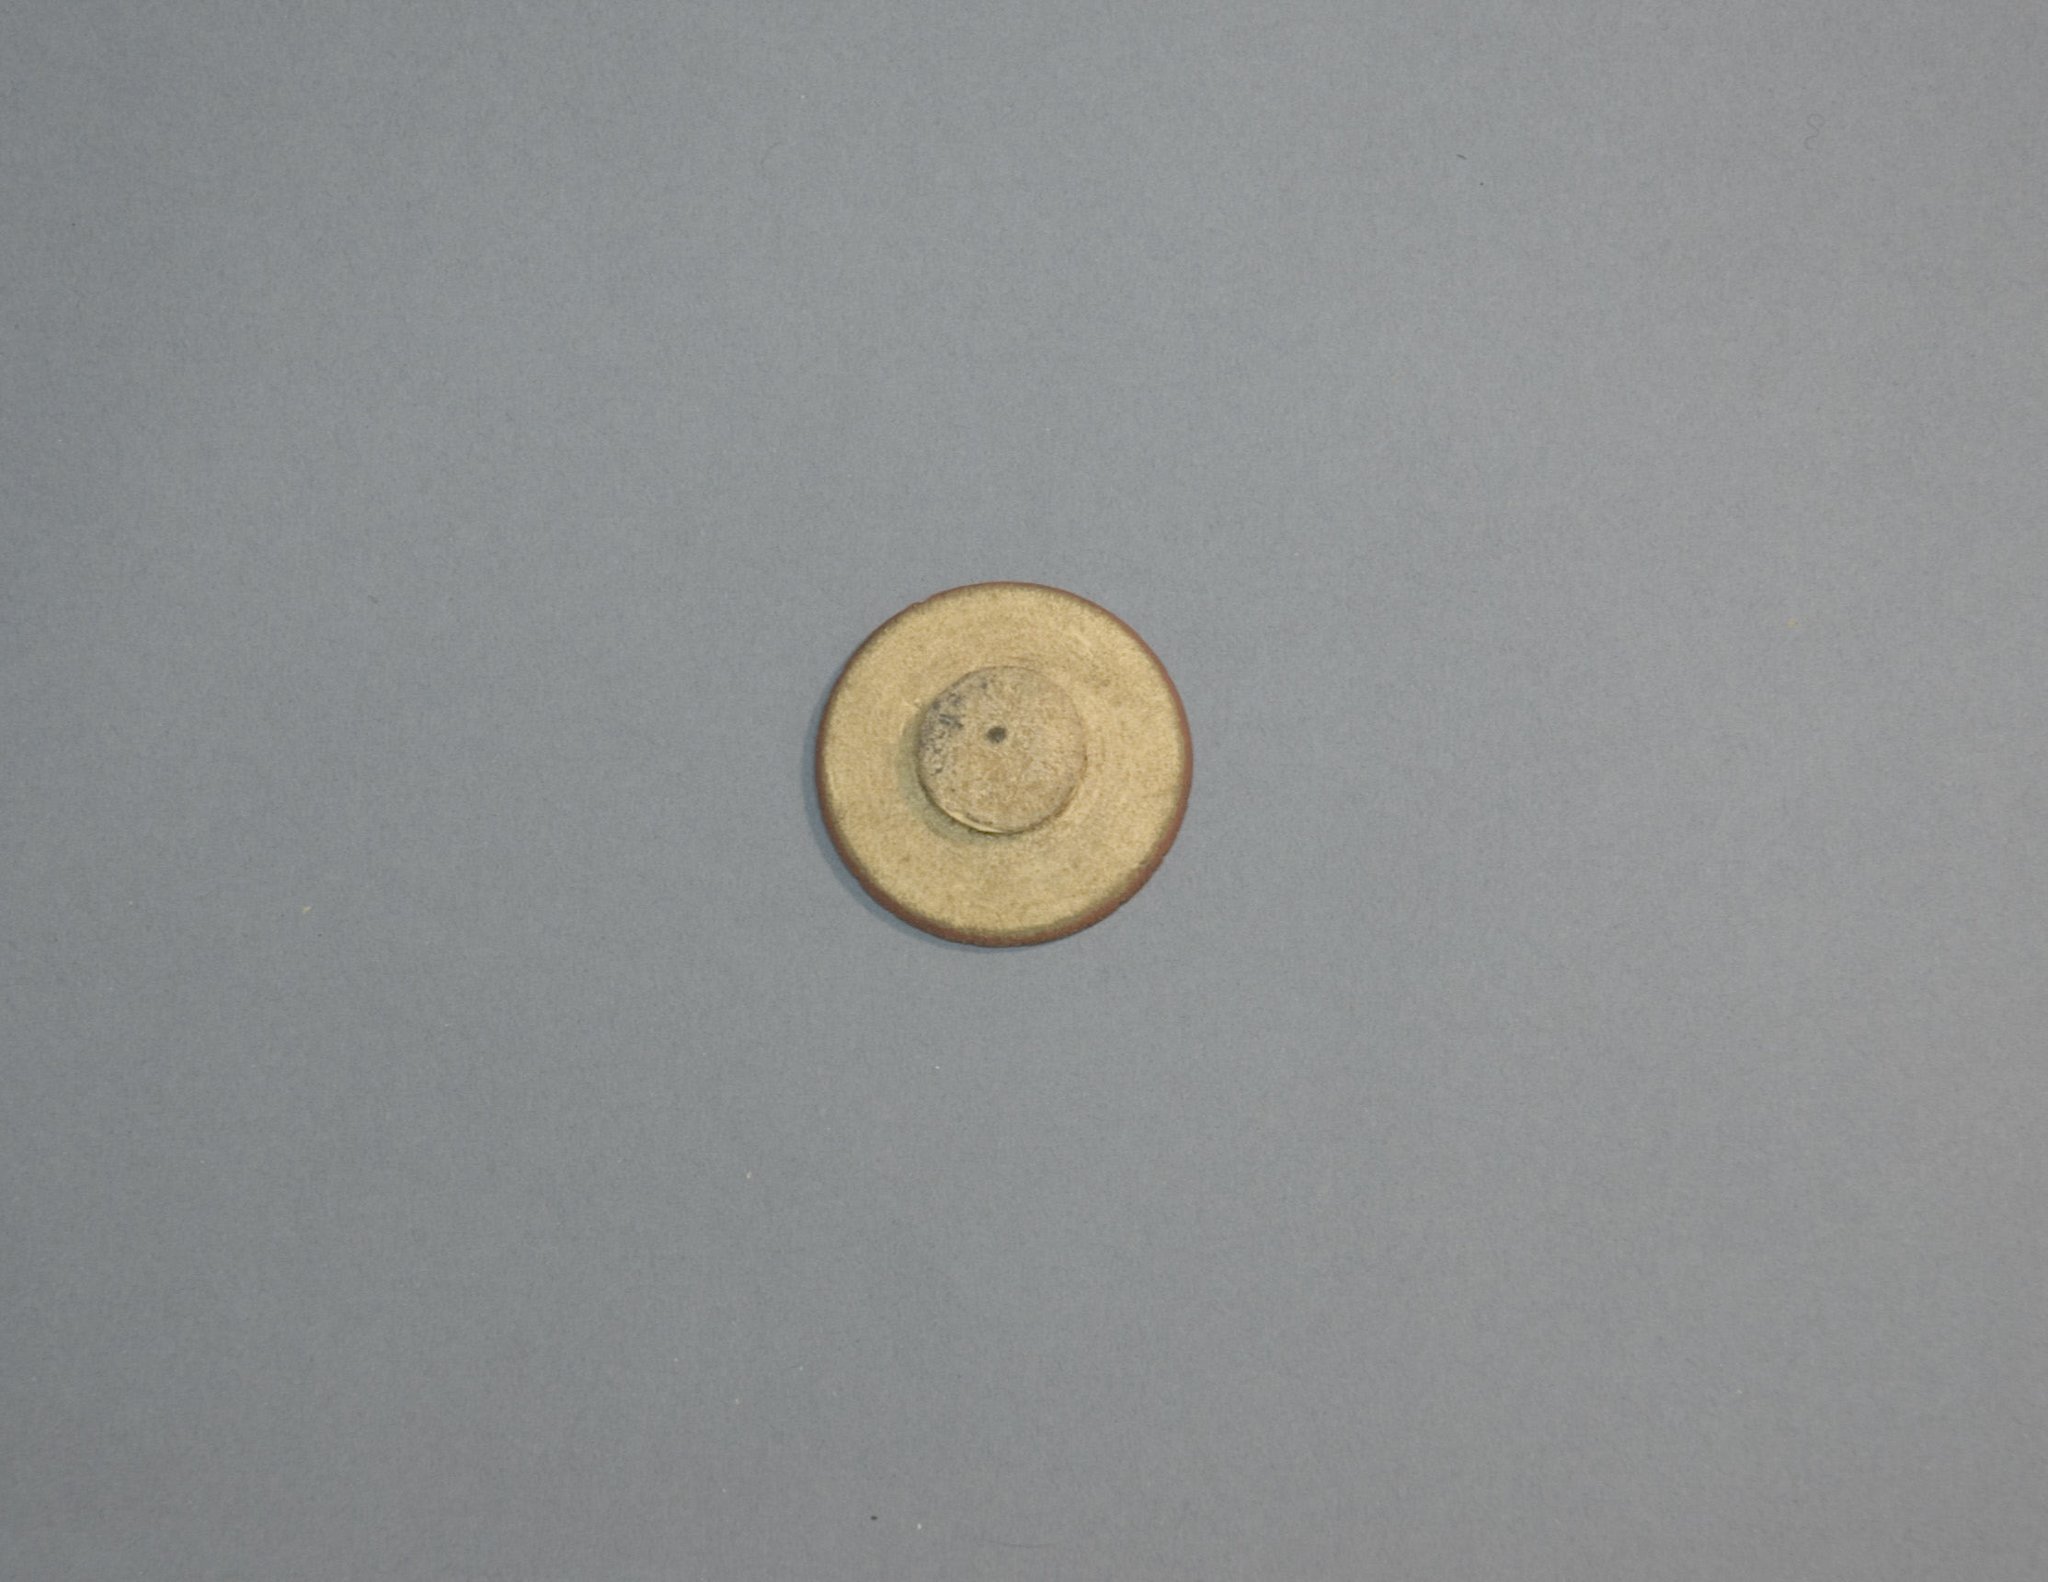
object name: jade carving tool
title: Small polishing wheel for carving jade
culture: chinese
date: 1901-2000